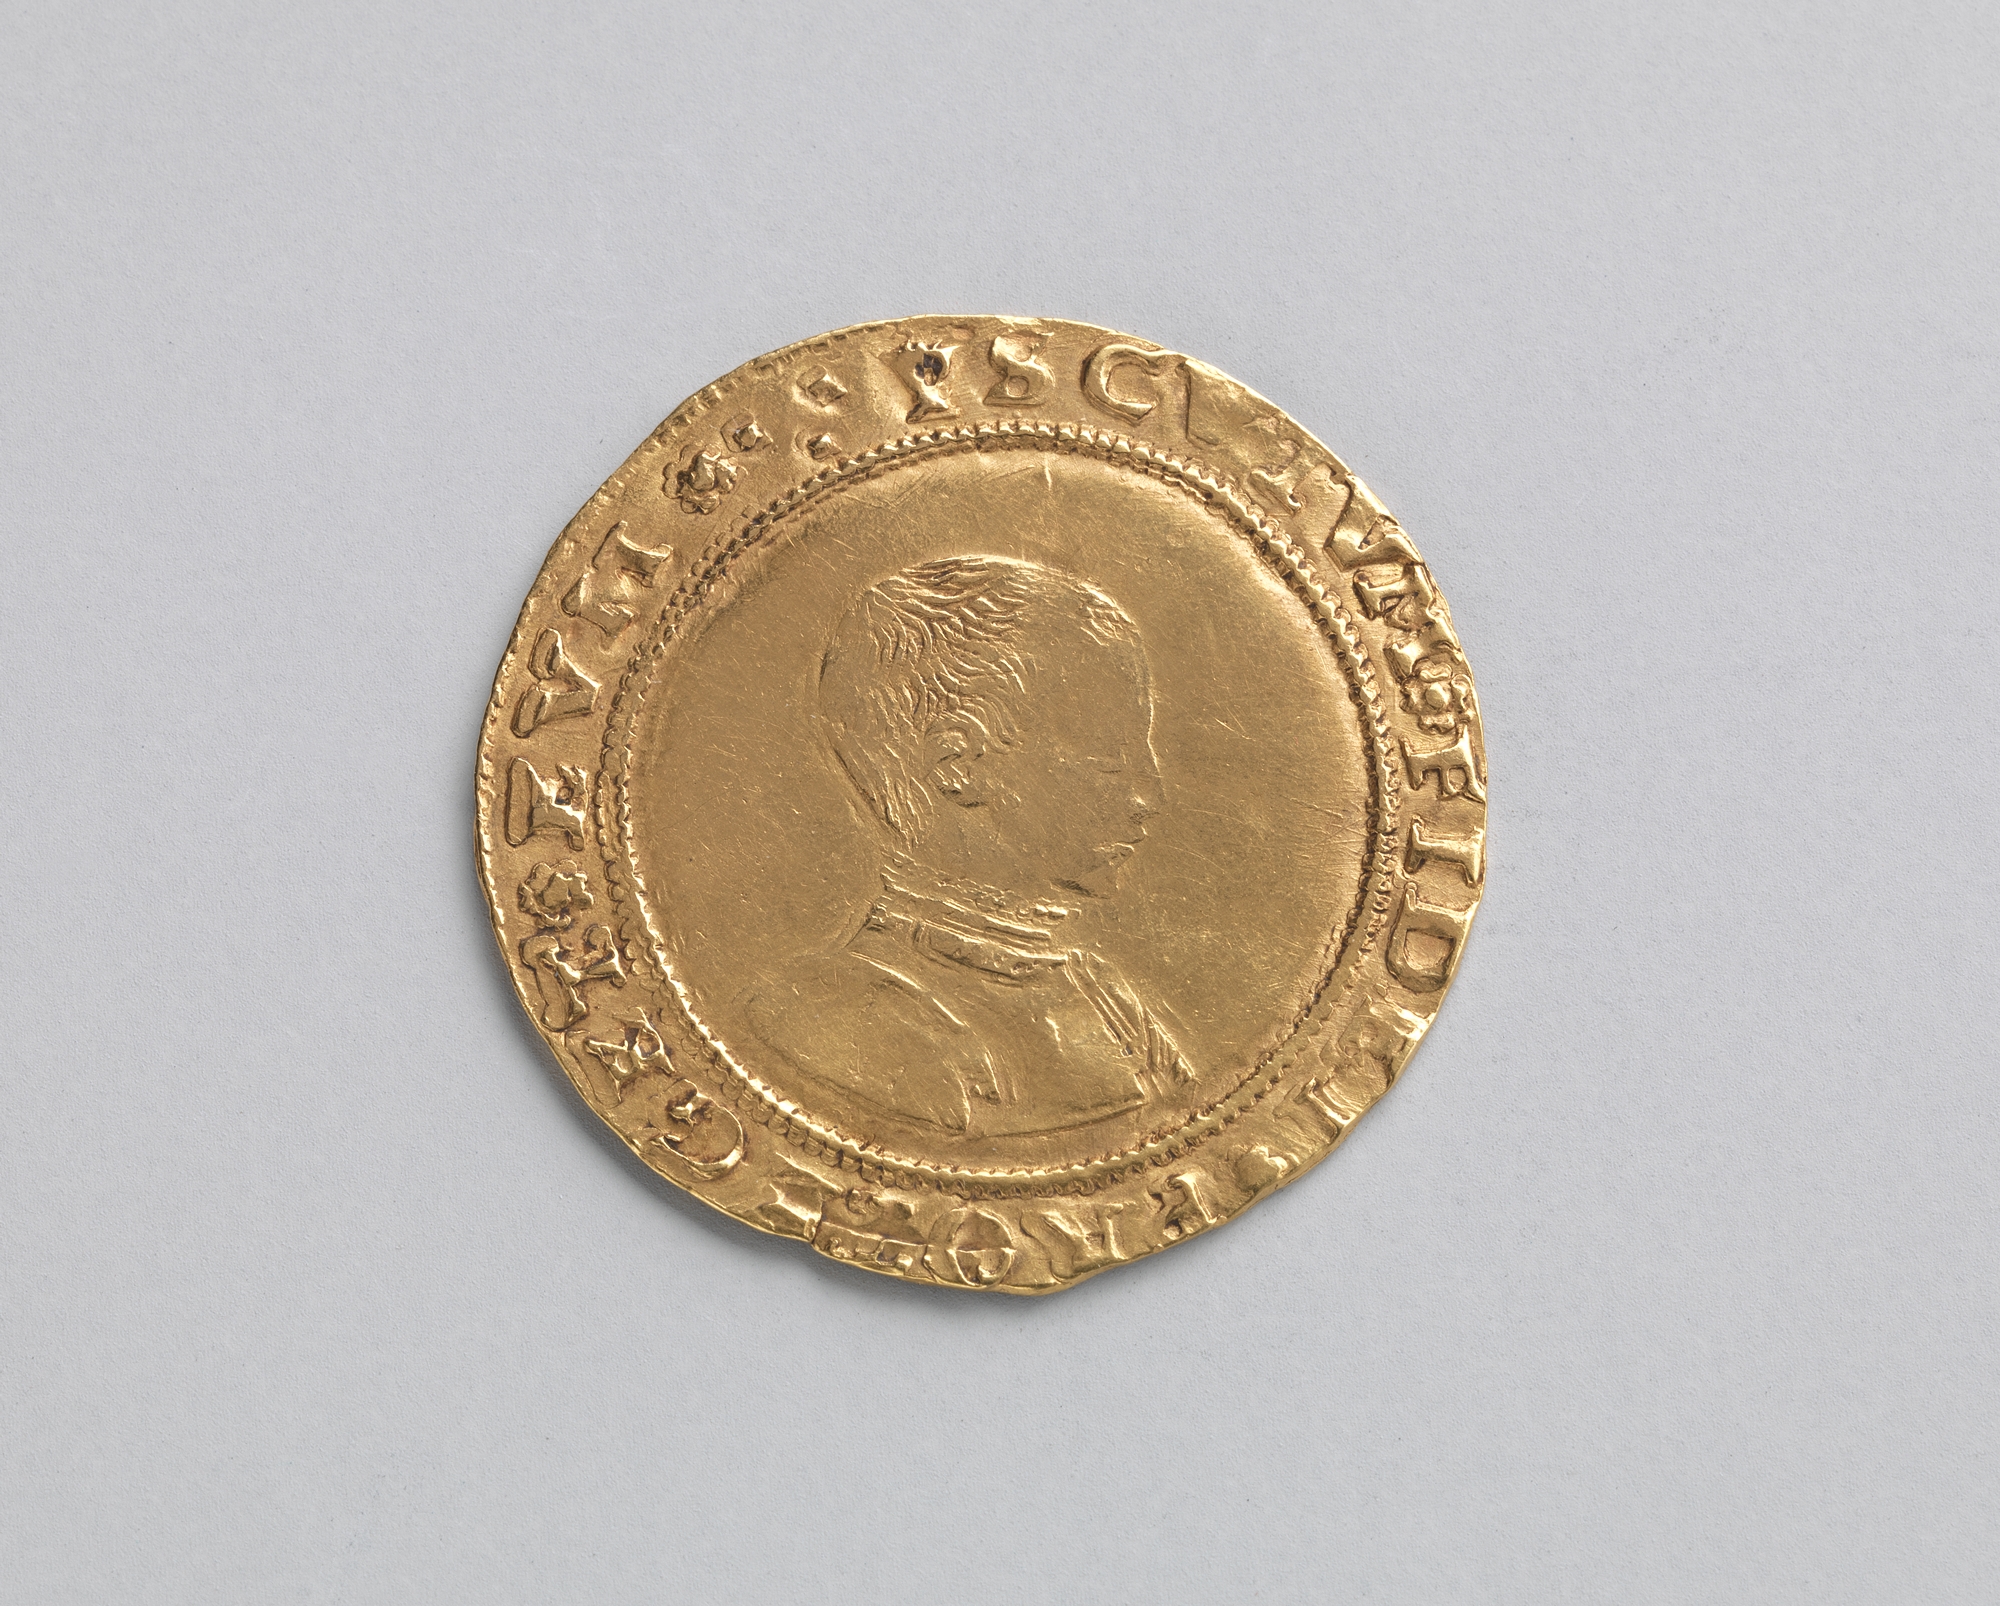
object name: half sovereign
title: Half sovereign of Edward VI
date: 1549-1550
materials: gold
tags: kings,profiles,coat of arms